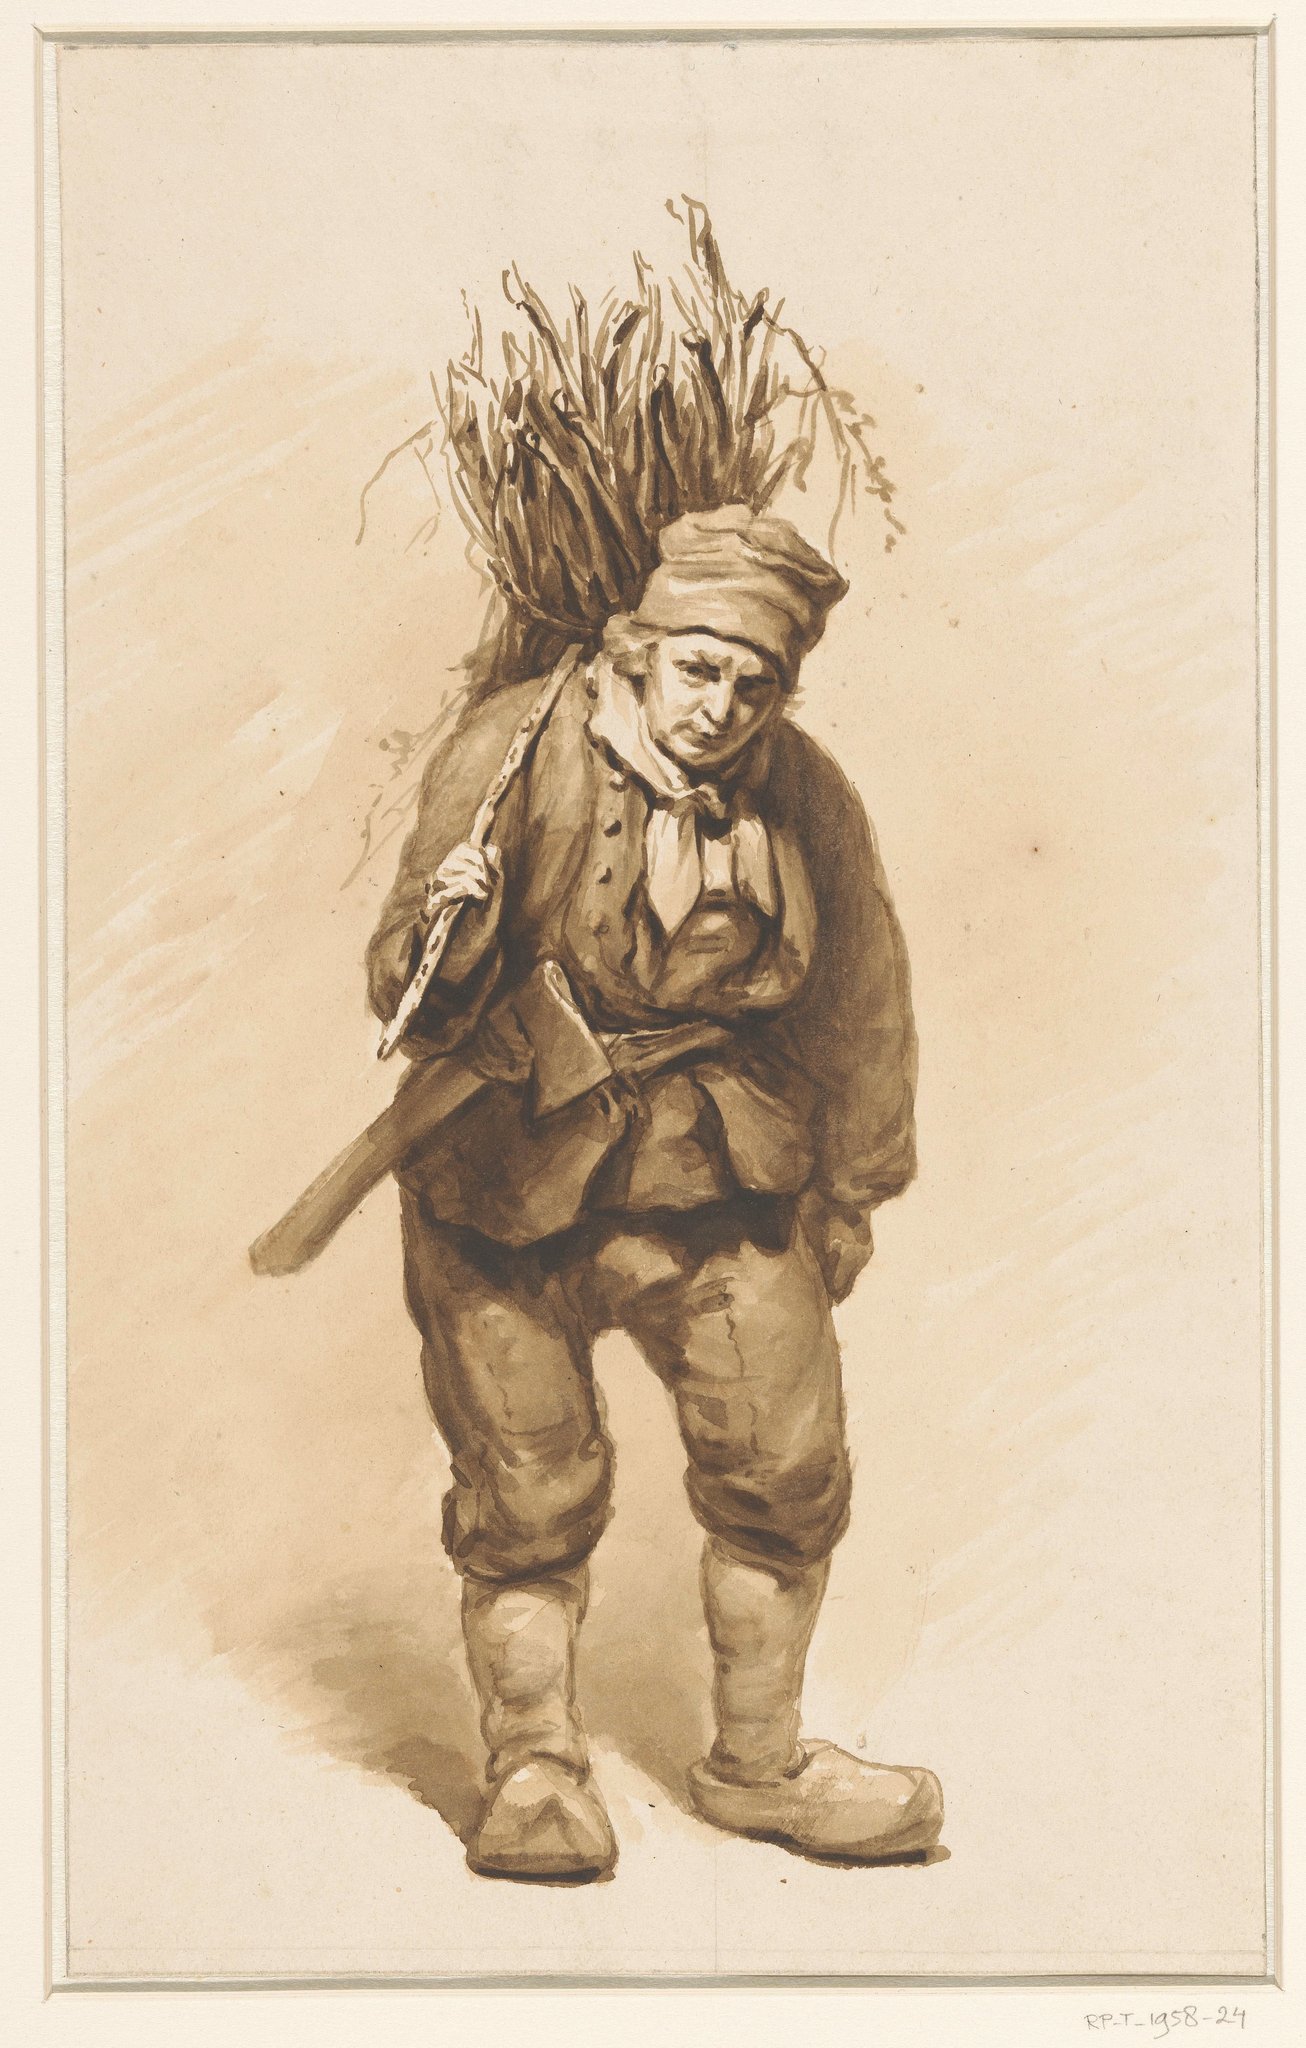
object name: drawing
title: Houthakker met een takkenbos over de schouder en een bijl aan de gordel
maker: pieter christoffel wonder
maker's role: draughtsman, painter, print maker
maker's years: 1780-1852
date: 1790-1852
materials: paper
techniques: brush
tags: woodcutting, woodcutter ~ forestry